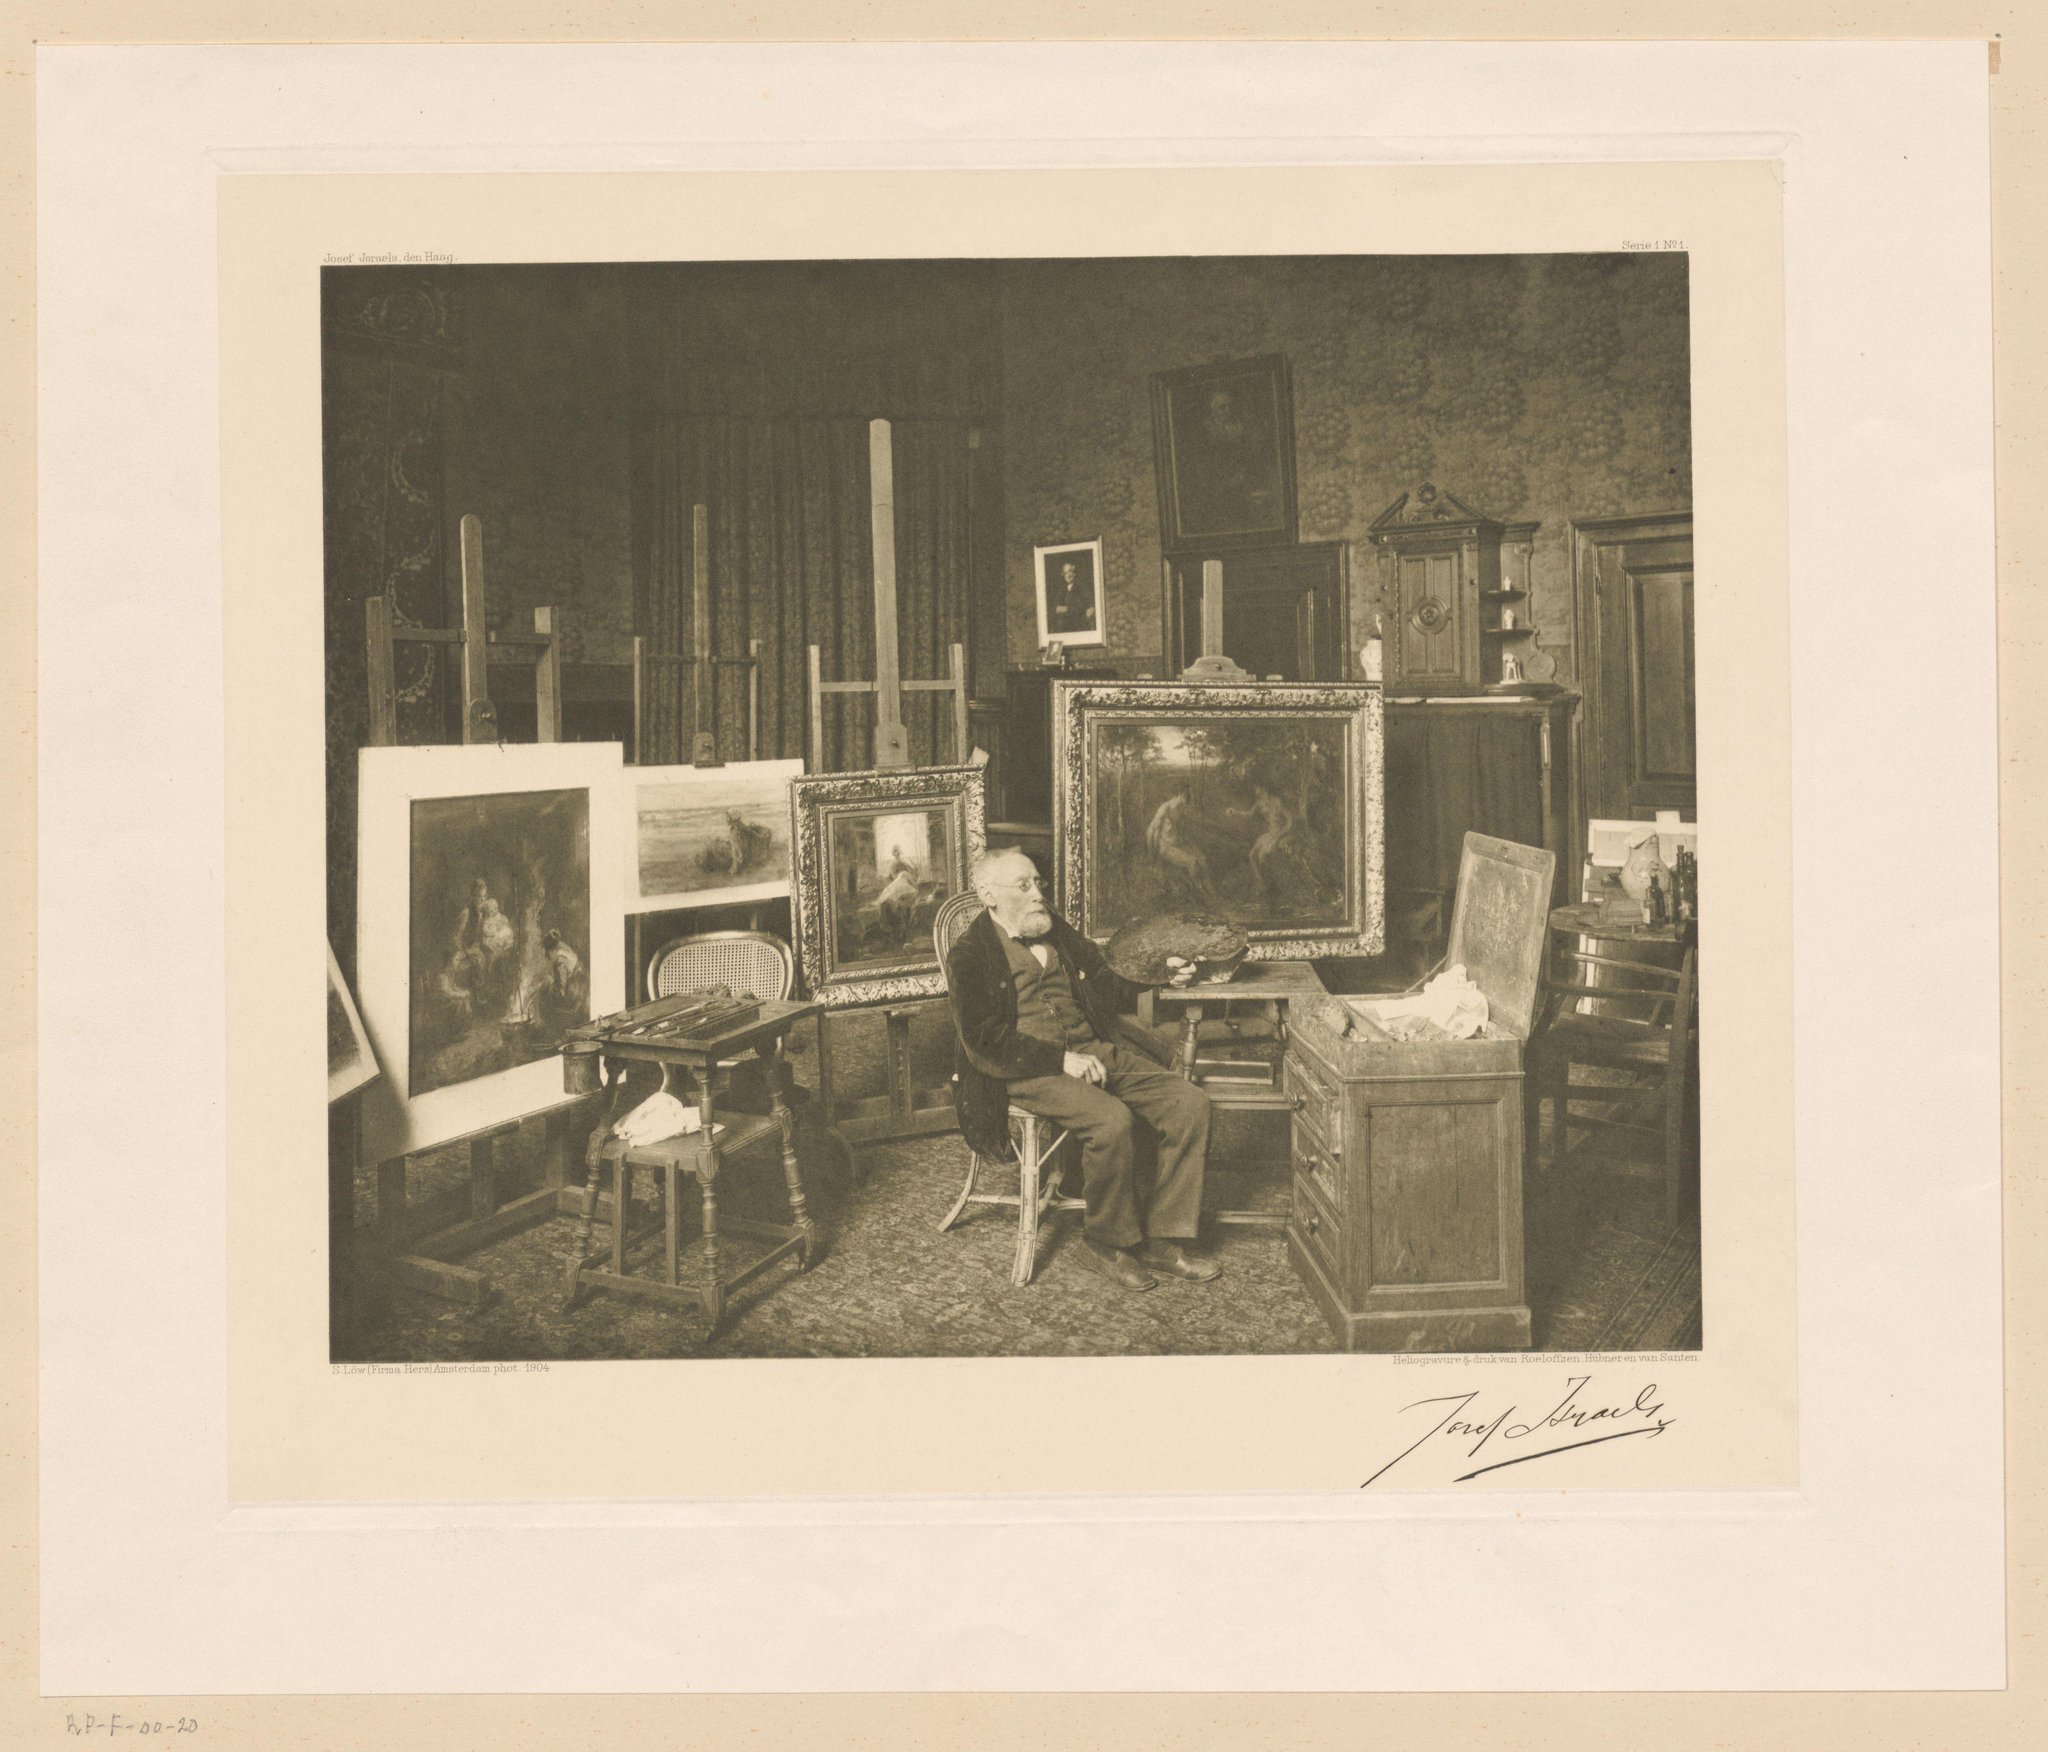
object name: photomechanical print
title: Portret van Jozef Israëls in zijn atelier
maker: sigmund löw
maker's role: publisher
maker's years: 1845-1920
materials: paper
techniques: photoaquatint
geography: amsterdam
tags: the hague, draughtsman, jozef israëls, historical persons, portrait, self-portrait of artist, artist at work, in his workshop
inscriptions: collector's mark: Lugt 2233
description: Deze prent maakt mogelijk deel uit van een serie kunstenaarsportretten die als heliogravures zijn uitgegeven naar foto's van Sigmund Löw.